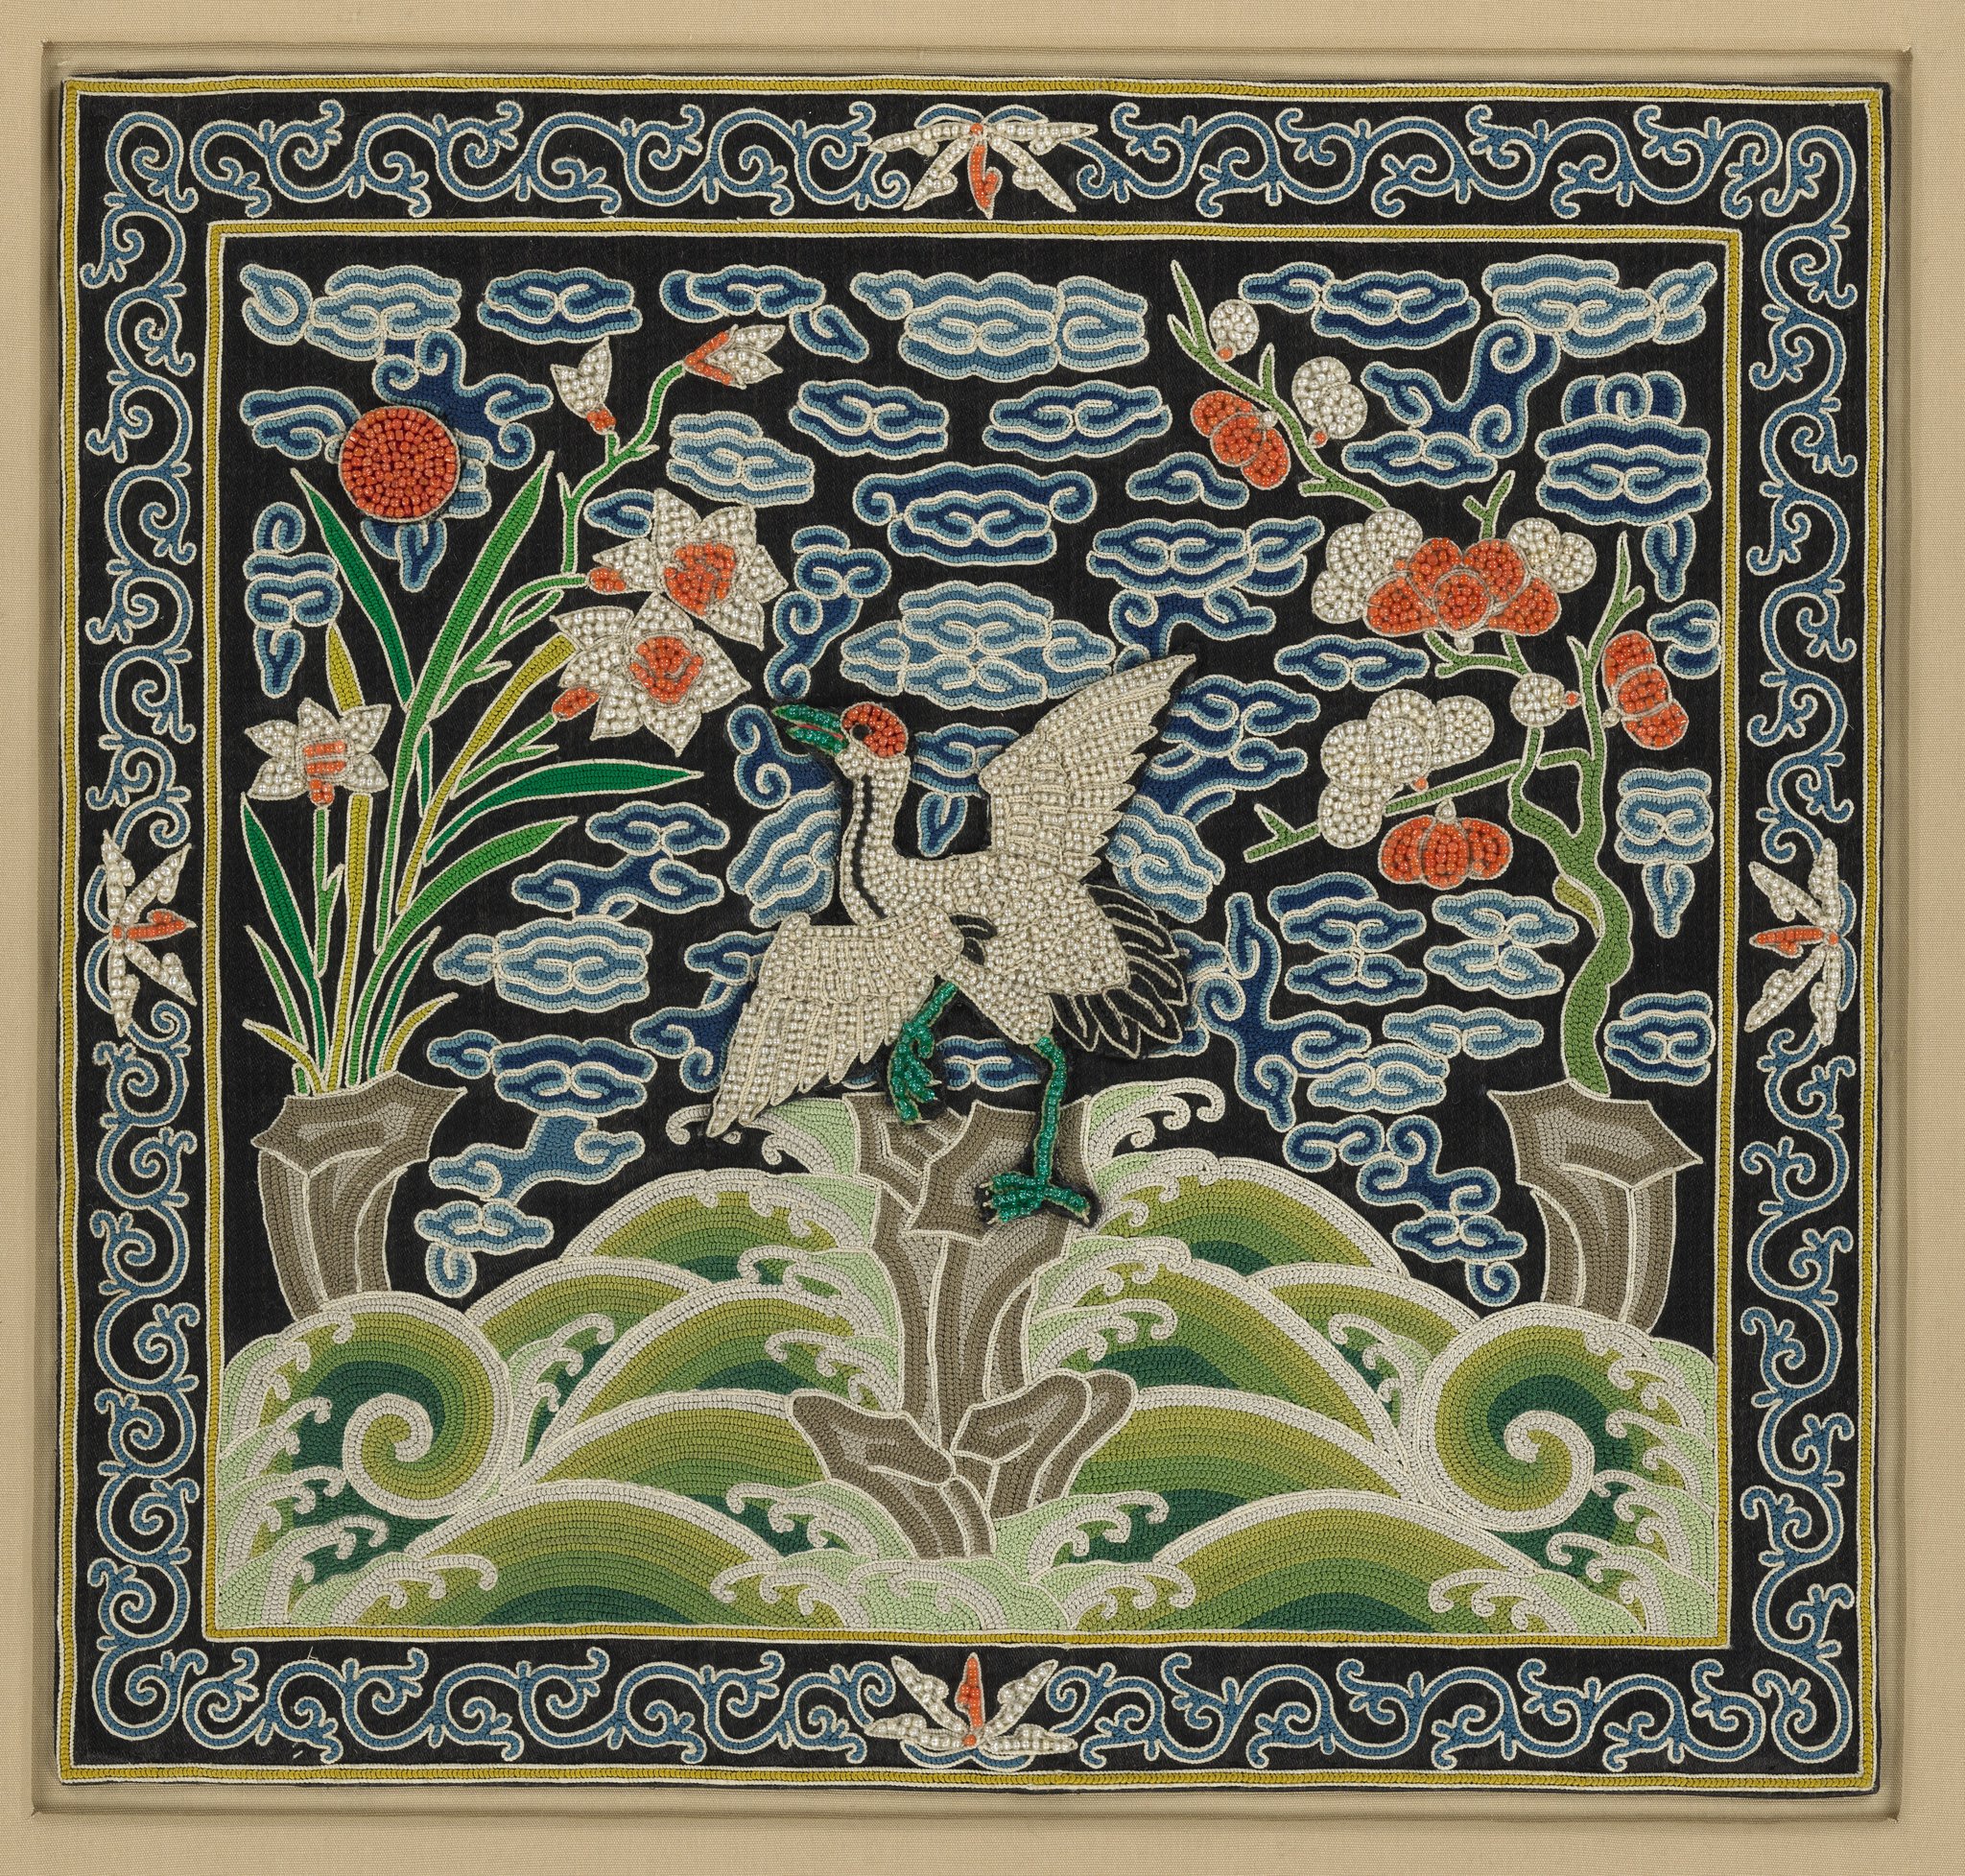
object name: rank badge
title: Rank badge with crane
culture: chinese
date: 1801-1900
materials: coral, glass, pearl, silk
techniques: embroidery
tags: cranes